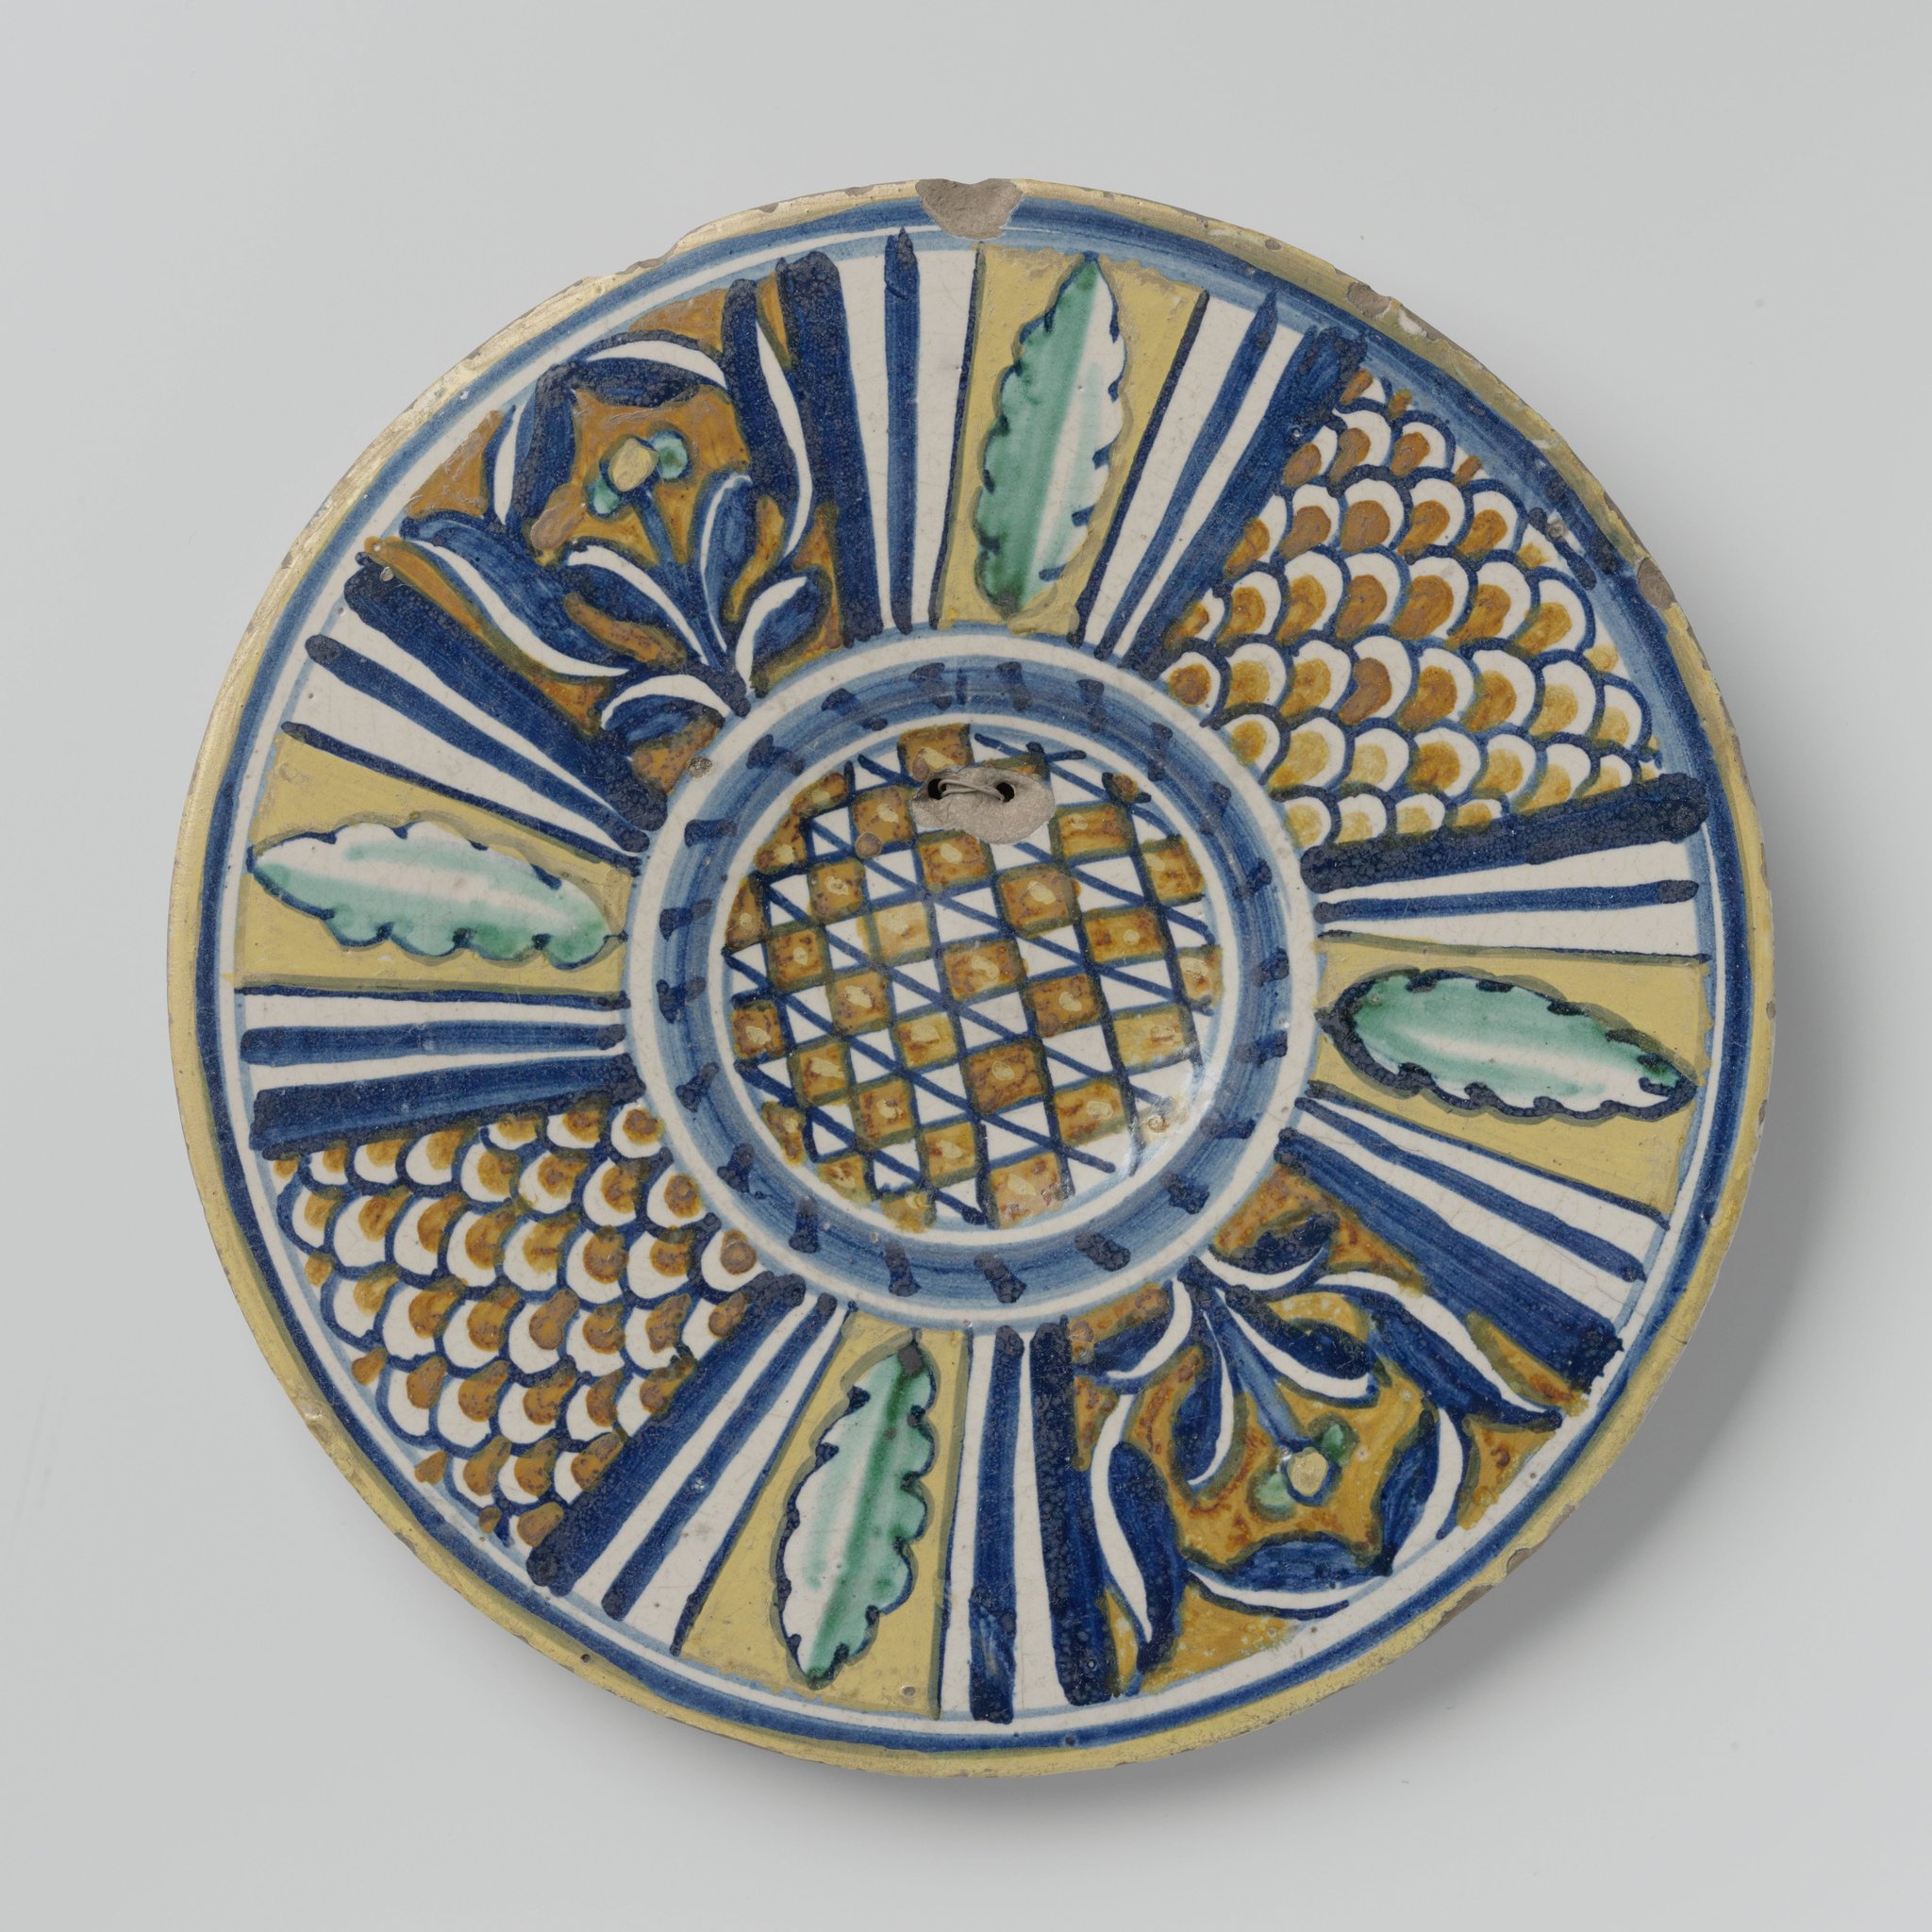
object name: plate dish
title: Bord met gestileerde motieven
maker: Anonymous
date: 1500-1530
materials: earthenware, glaze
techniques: maiolica, painted, polychromy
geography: deruta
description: Plate. Italy, possibly Deruta, c. 1500 - 1530.